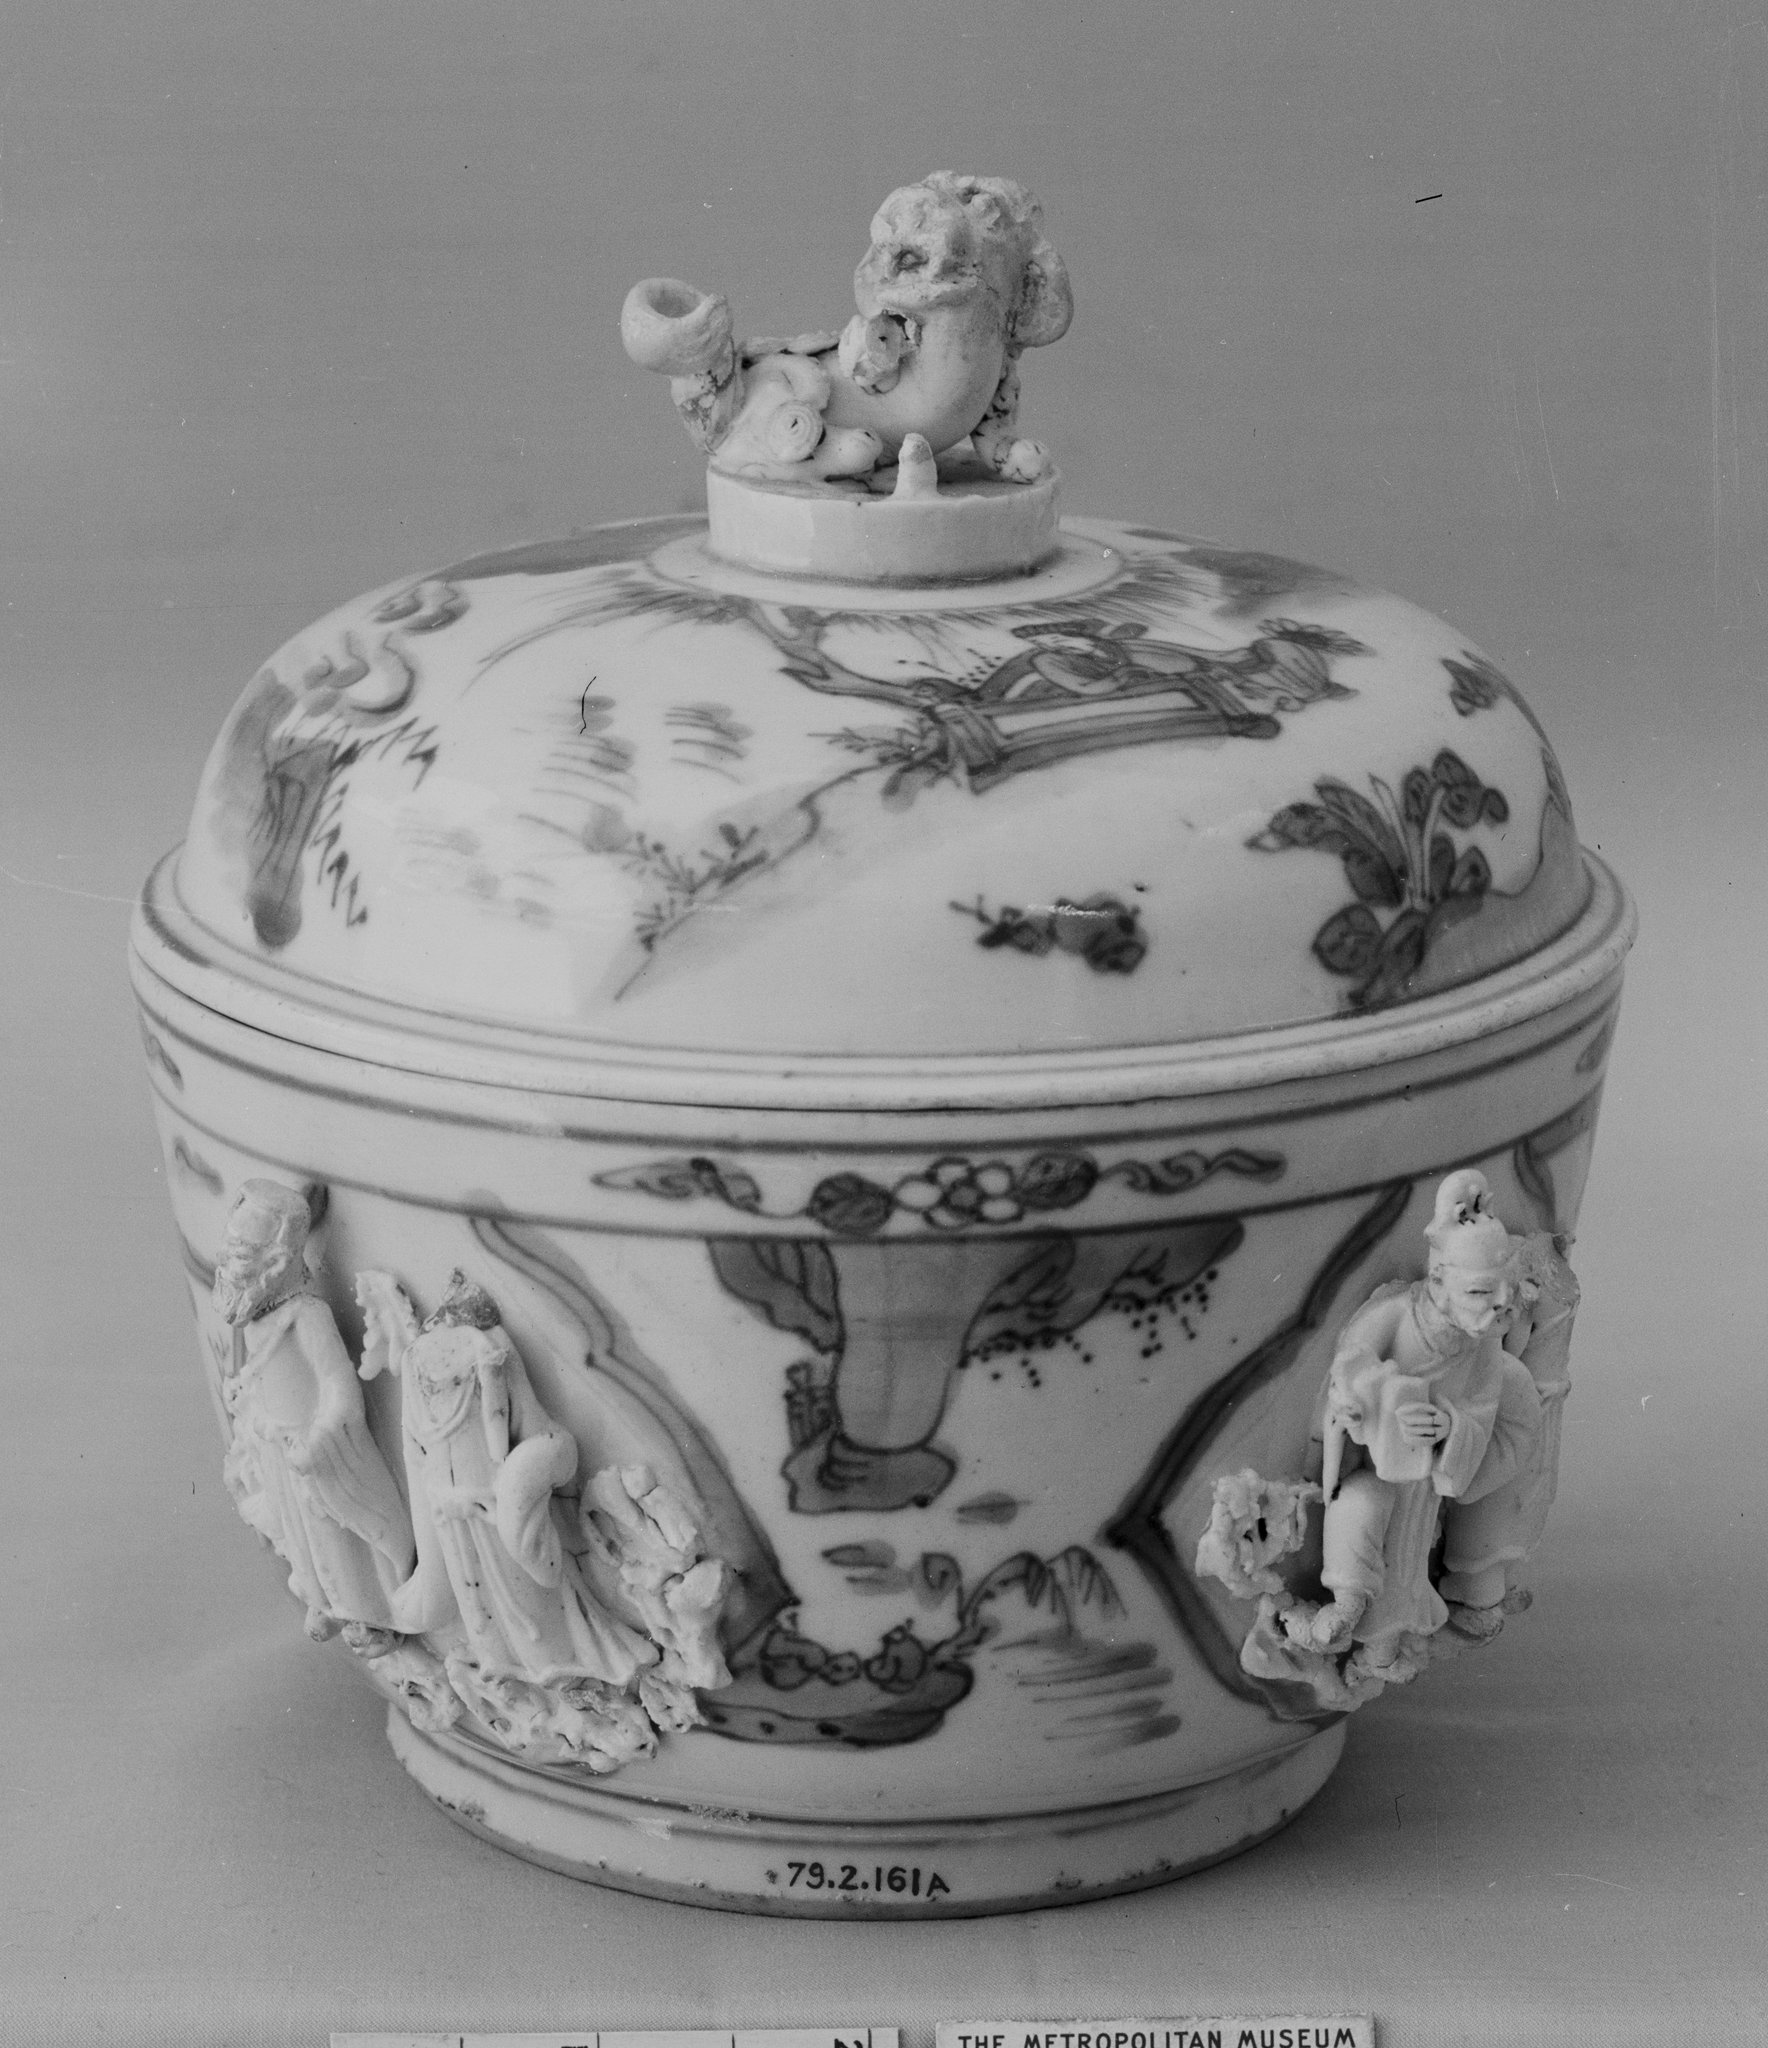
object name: covered bowl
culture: chinese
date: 1567-1633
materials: biscuit, porcelain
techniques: painting, relief, underglaze